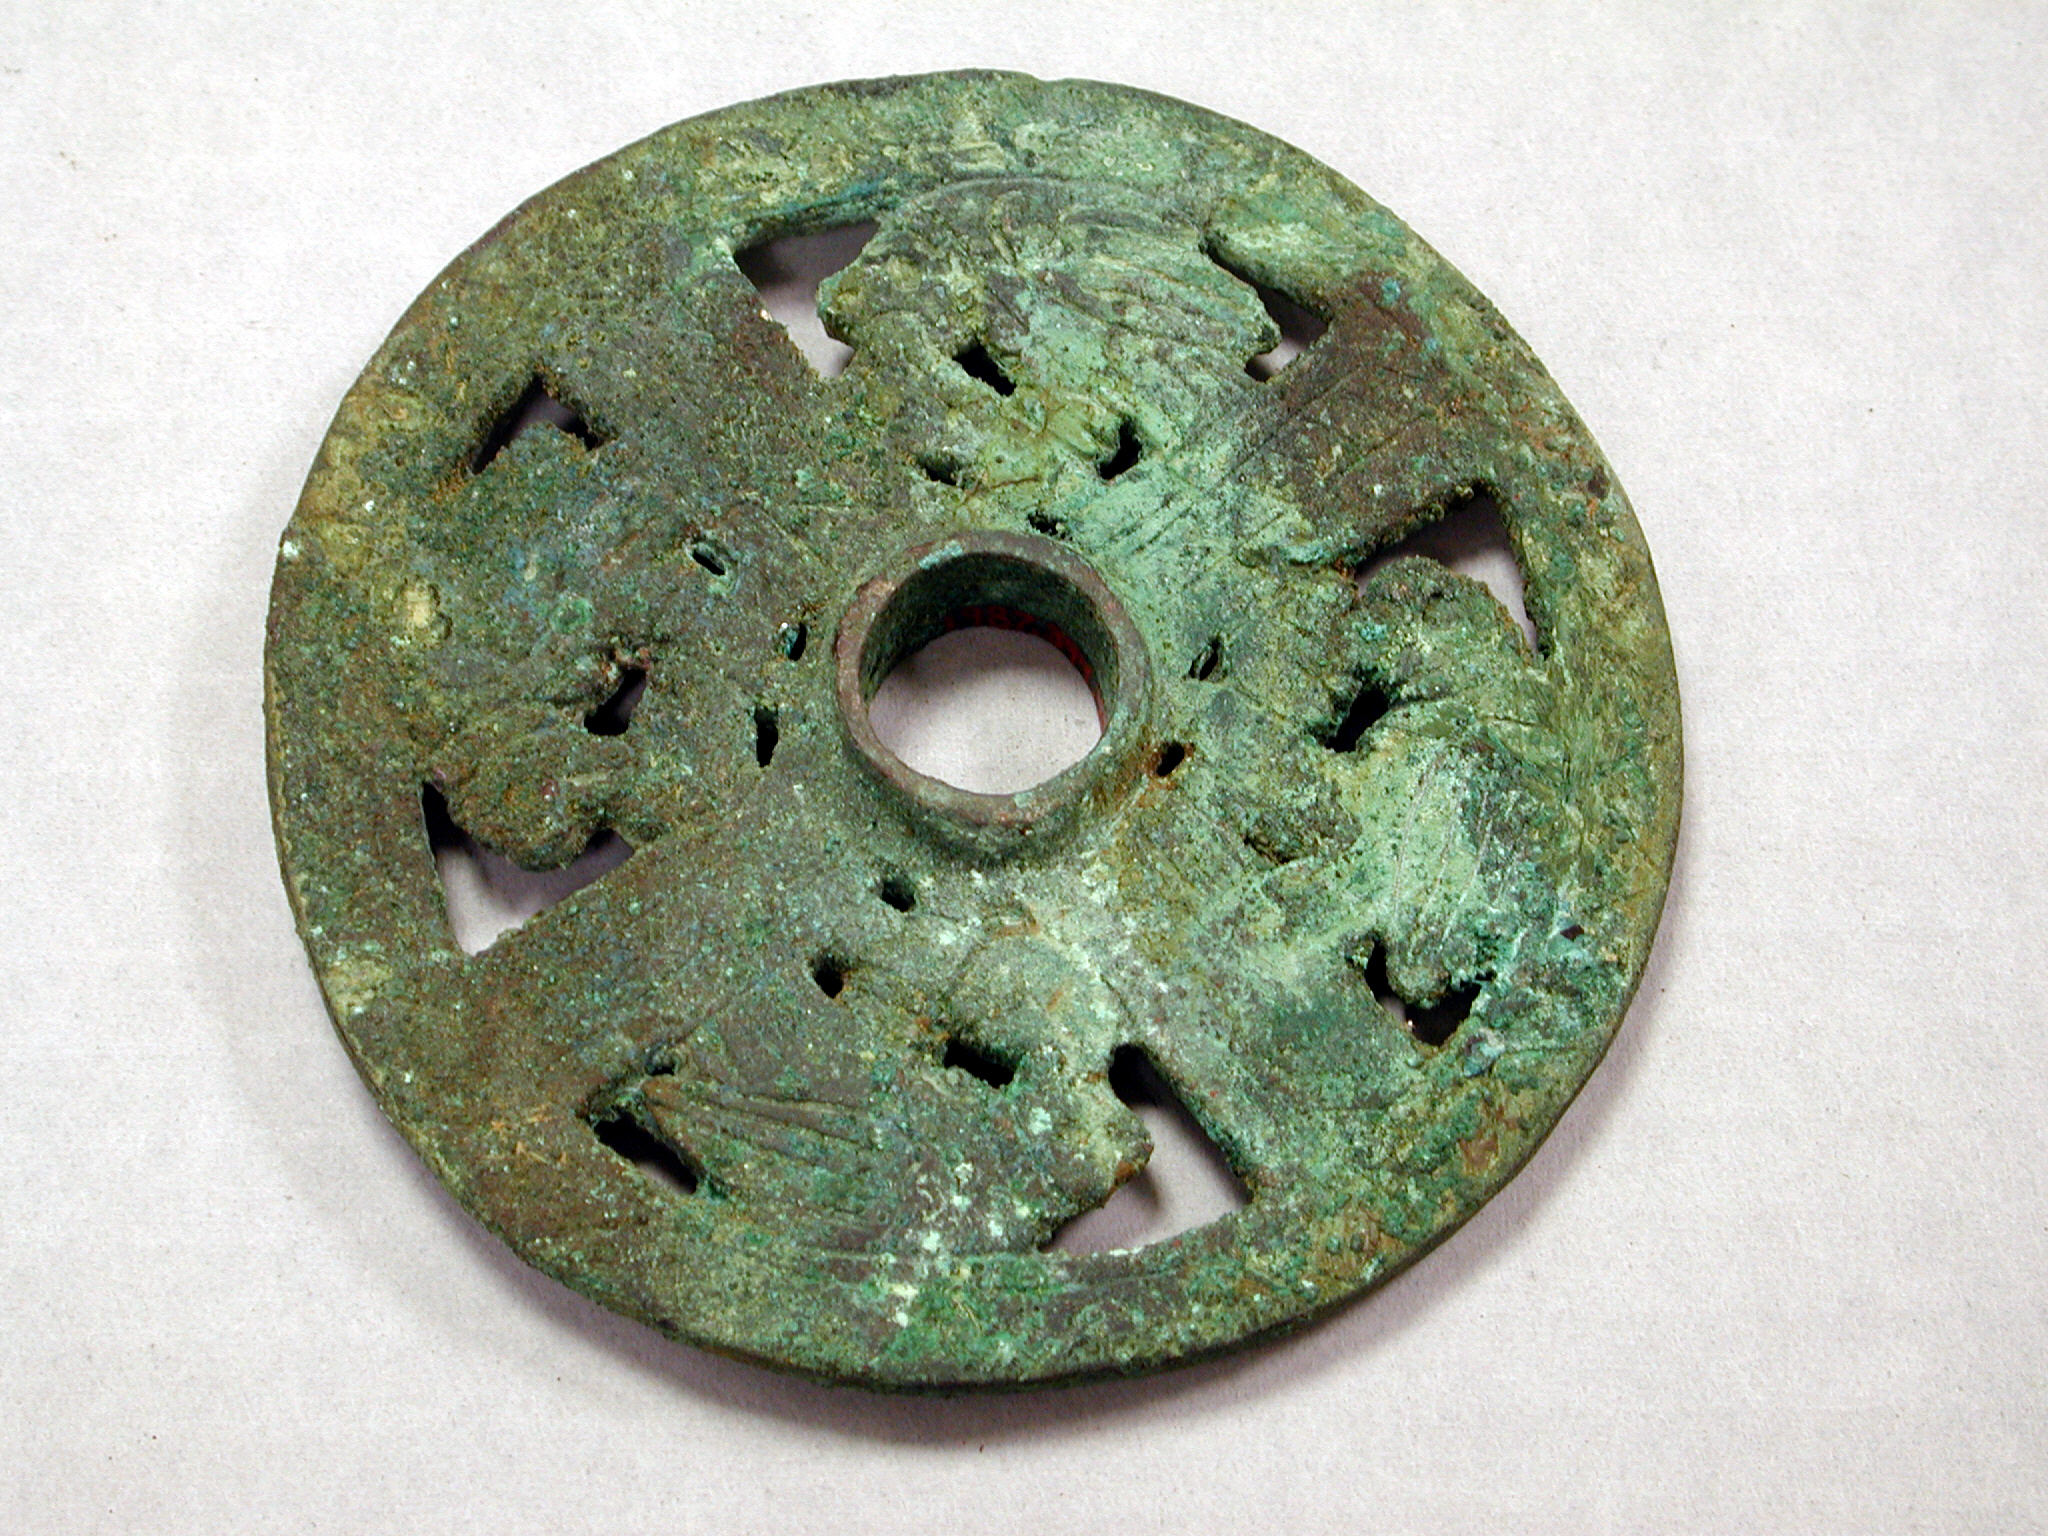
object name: mace head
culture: moche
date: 101-800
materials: copper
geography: peru